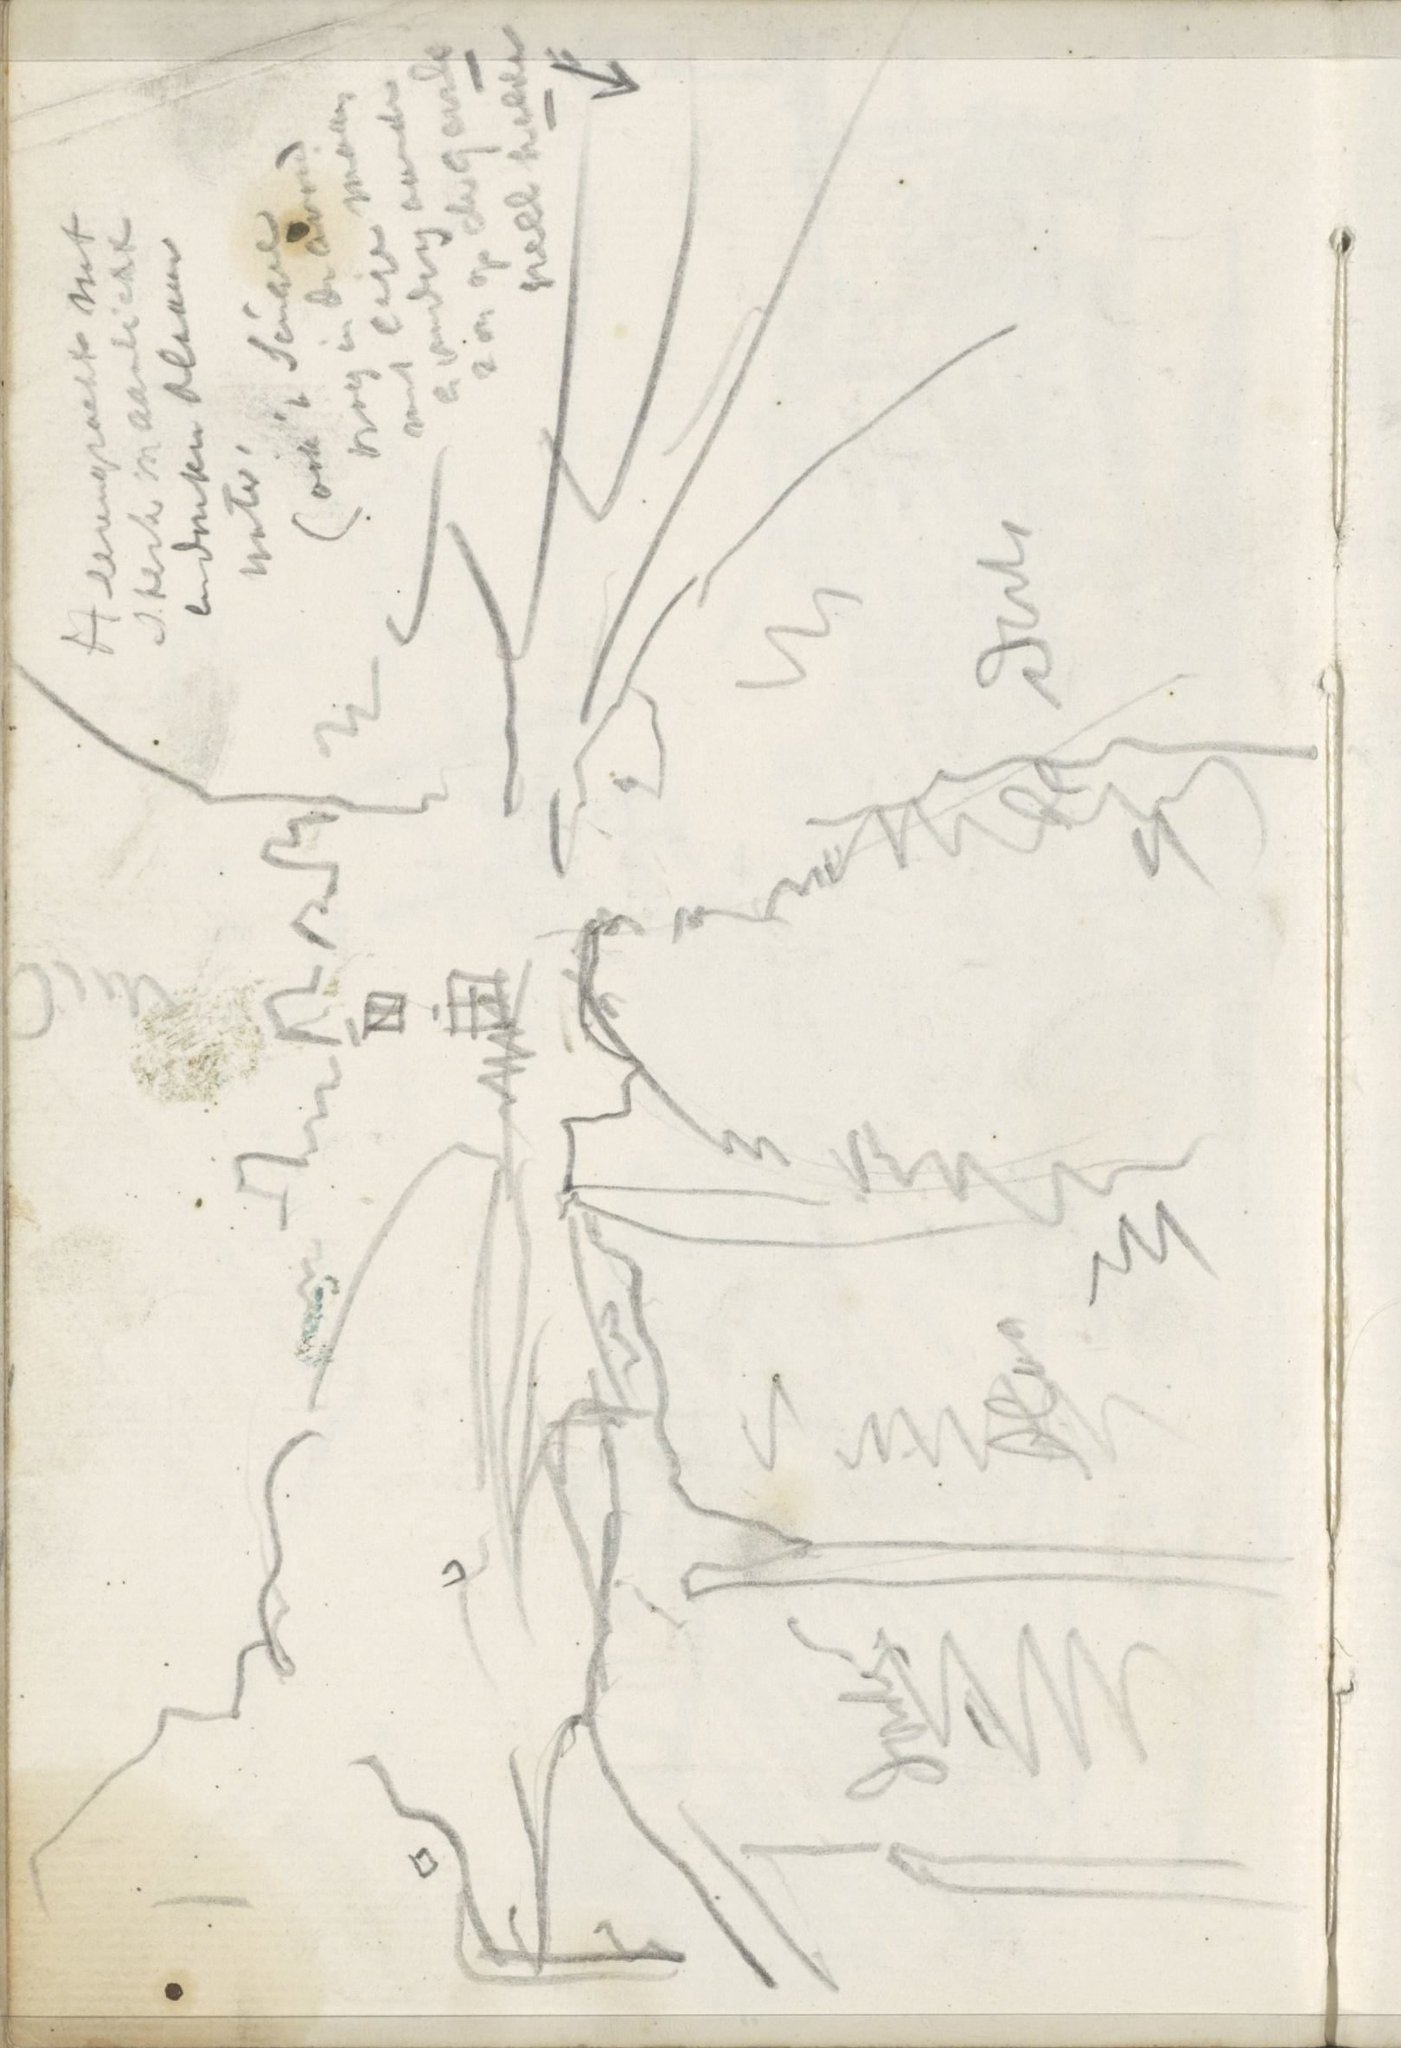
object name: sketchbook leaf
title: Gezicht op de Herengracht te Amsterdam bij maanlicht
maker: george hendrik breitner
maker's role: draughtsman, painter, print maker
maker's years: 1857-1923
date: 1895-1898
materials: paper, pencil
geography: amsterdam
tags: canals, waters (in city), civic architecture; edifices; dwellings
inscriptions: annotation: ‘Heerengracht met/ sterk maanlicht/ en donker blaauw/ water/ (ook 't Singel/ vroeg in de avond/ [...]’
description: Pagina 27 uit een schetsboek met 21 bladen.